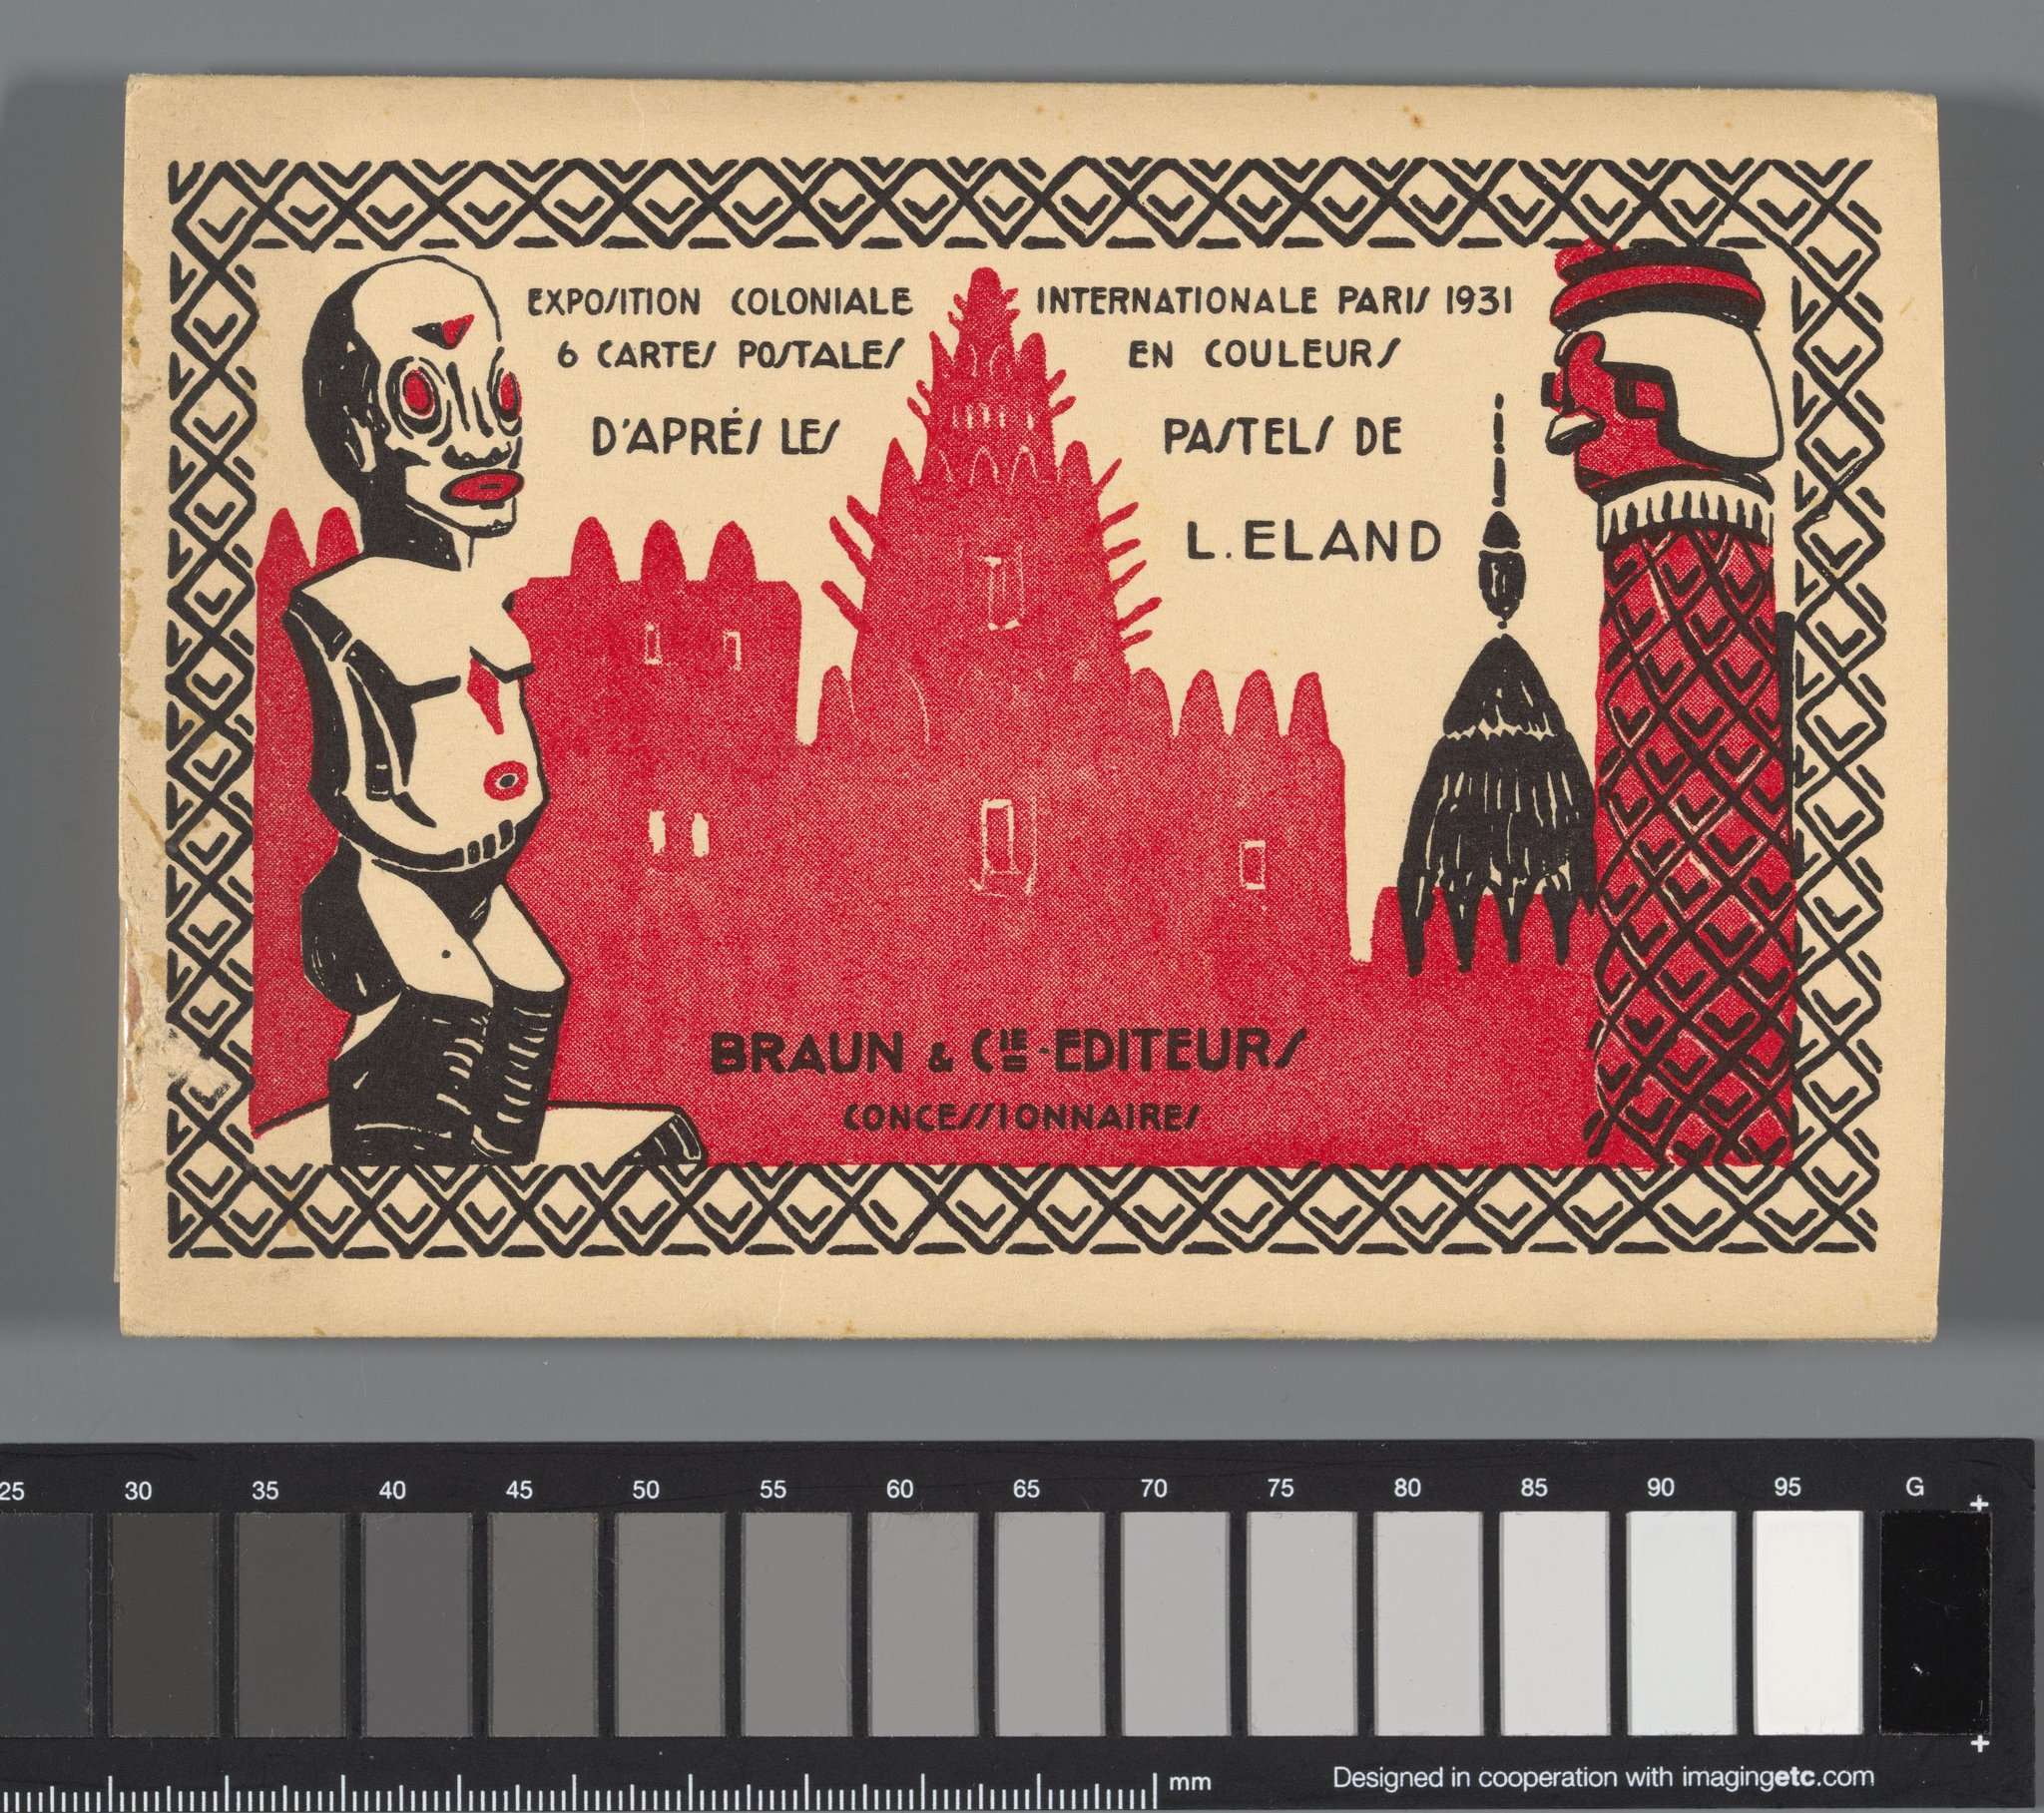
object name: ansichtkaart, prentbriefkaart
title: Exposition coloniale internationale Paris 1931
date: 1931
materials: paper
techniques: printing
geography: paris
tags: paris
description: Mapje met 6 ansichtkaarten in kleur over de Internationale Koloniale Tentoonstelling Parijs 1931, naar de pastels van L. Eland. Een kaart stelt het Pavillon des Pays Bas voor, de overigen hebben betrekking op de Franse koloniale geschiedenis